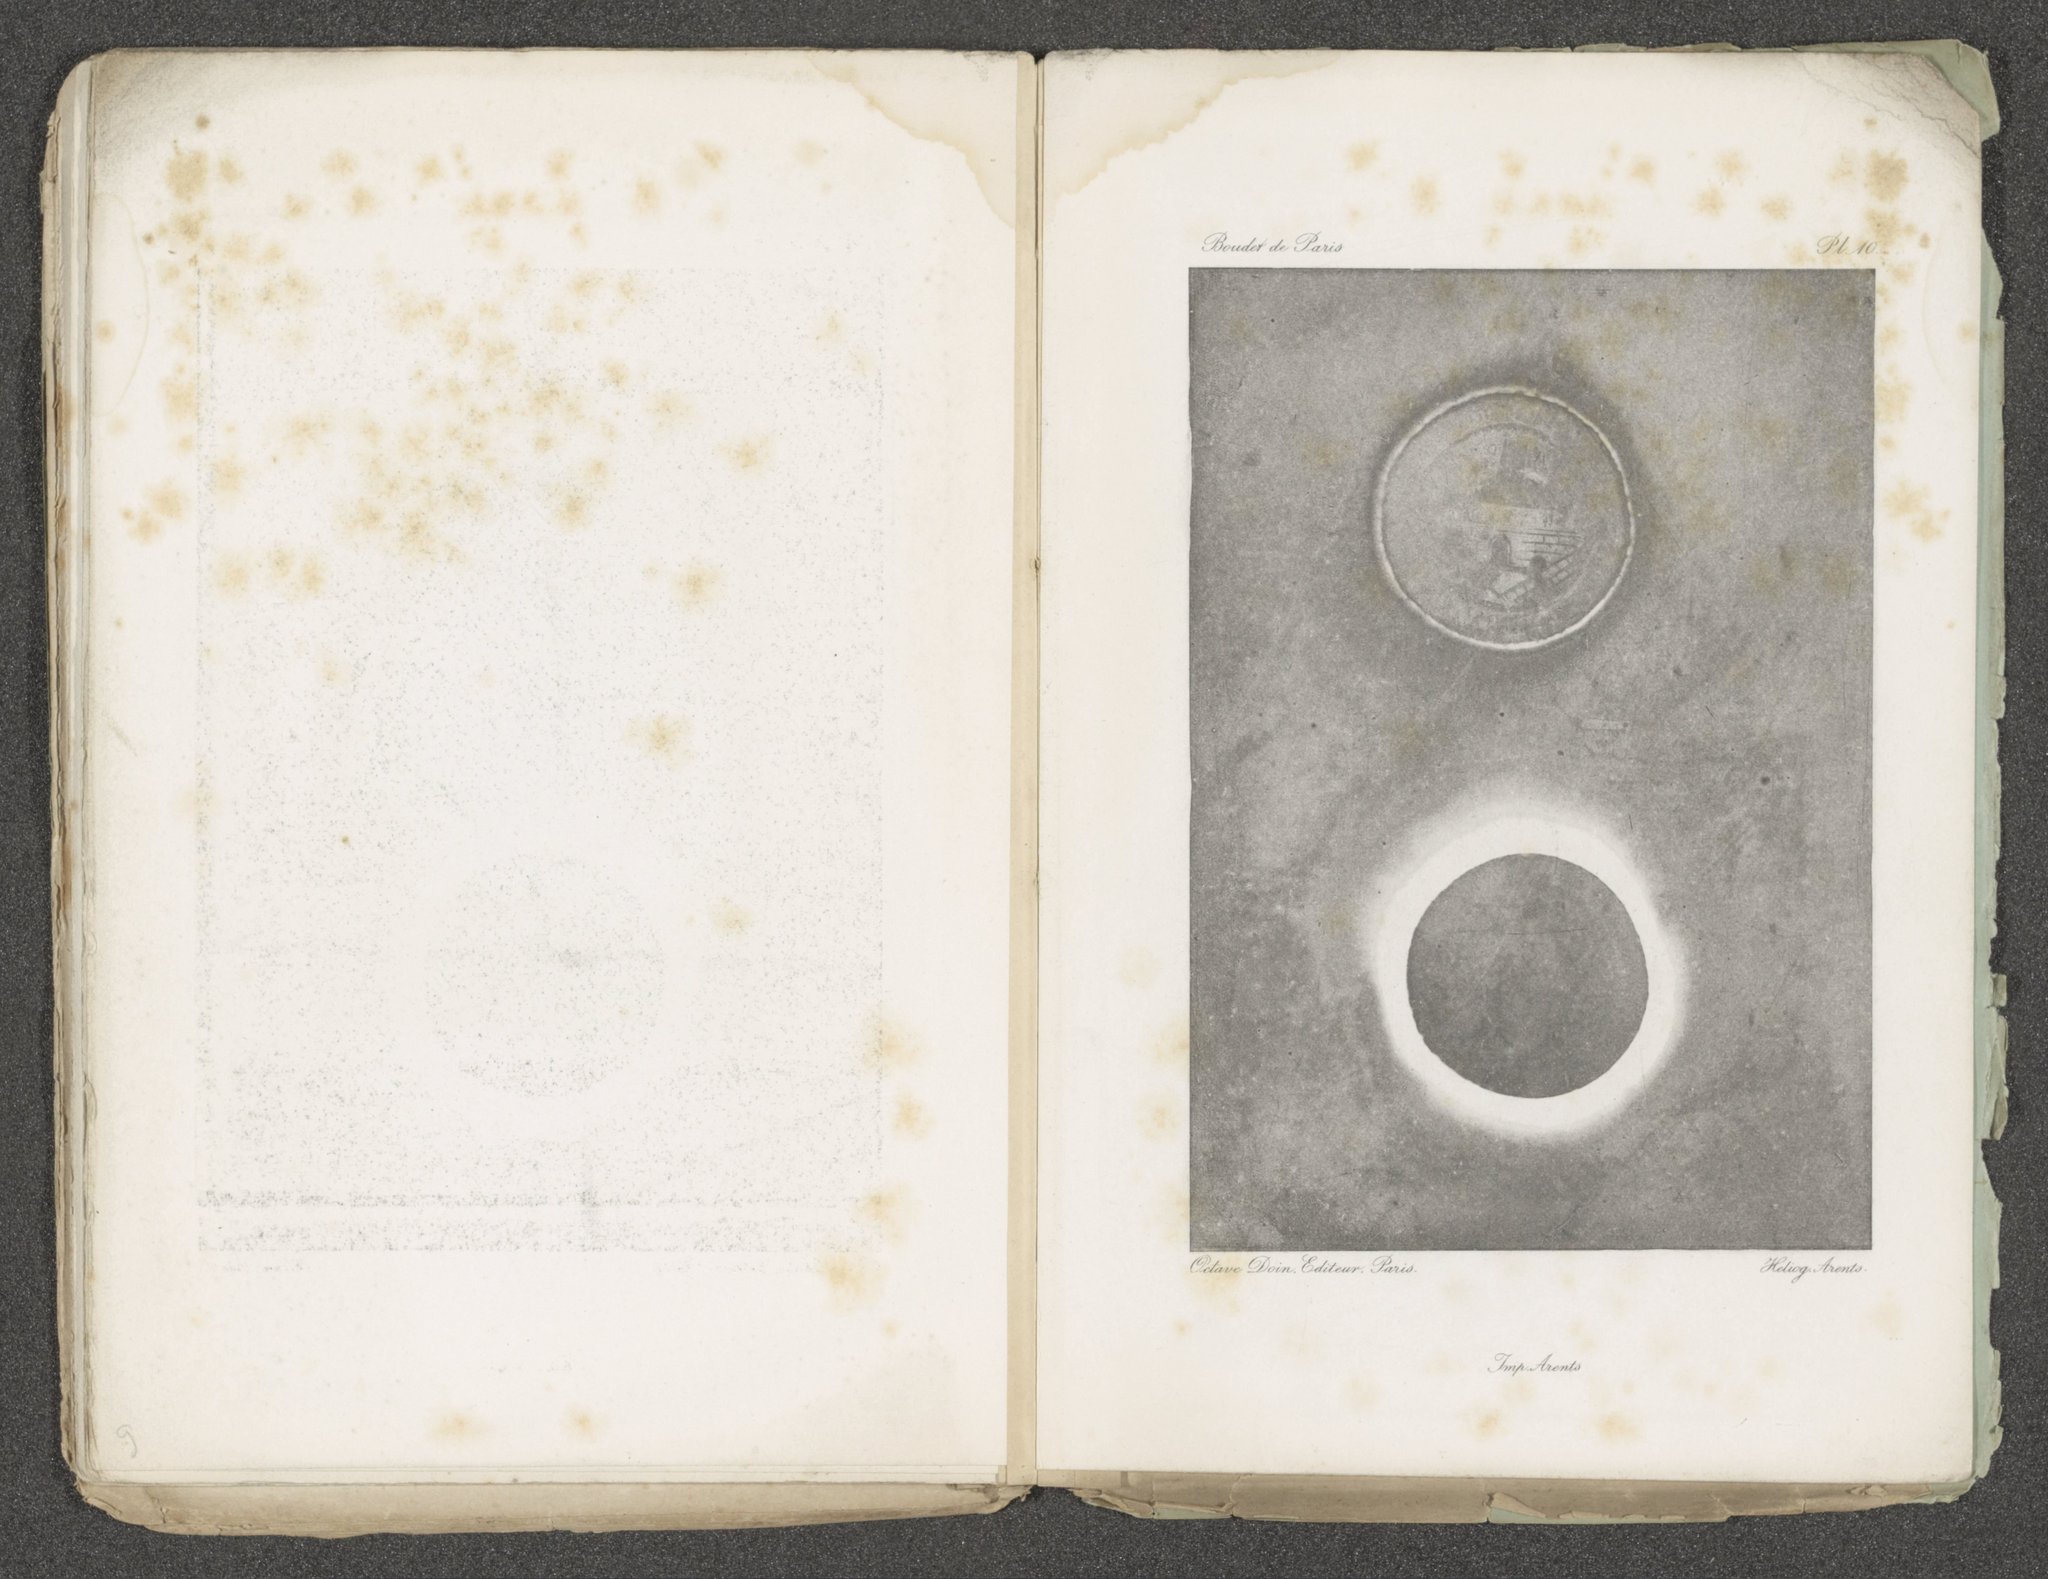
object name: photomechanical print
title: Twee munten met een halo van elektrische stroom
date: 1876-1886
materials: paper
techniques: photoaquatint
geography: paris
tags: electrical phenomena, coin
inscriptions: number: ‘Pl. 10.’